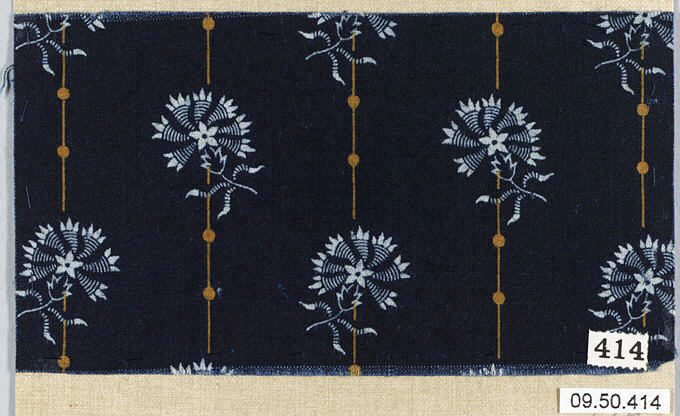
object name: piece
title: Piece (one of 116)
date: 1801-1900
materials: cotton